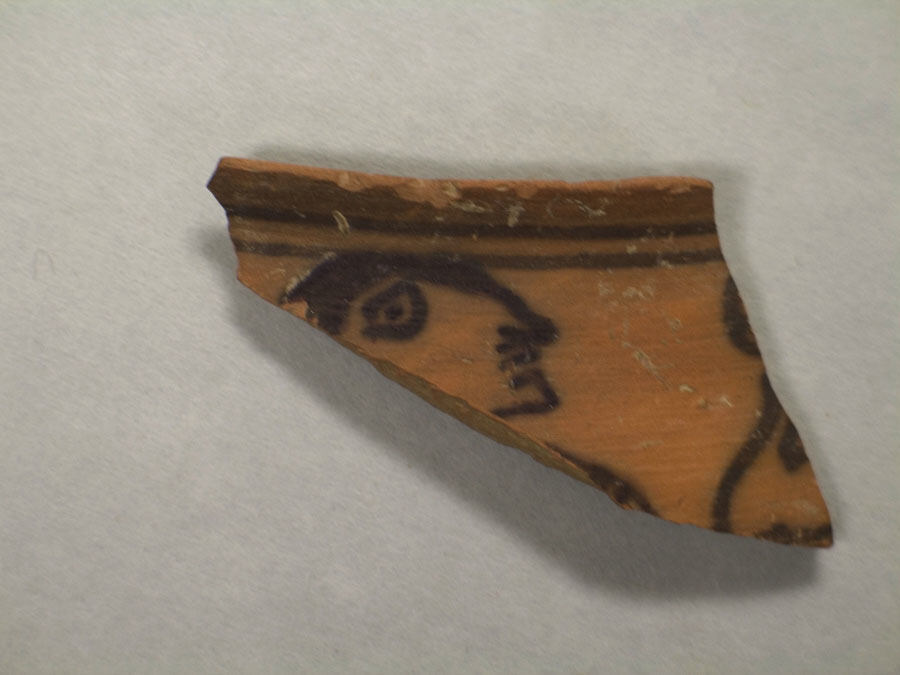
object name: shard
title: Shard: Head of Offerer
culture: pakistani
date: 301-500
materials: terracotta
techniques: painting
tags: gandhara,heads